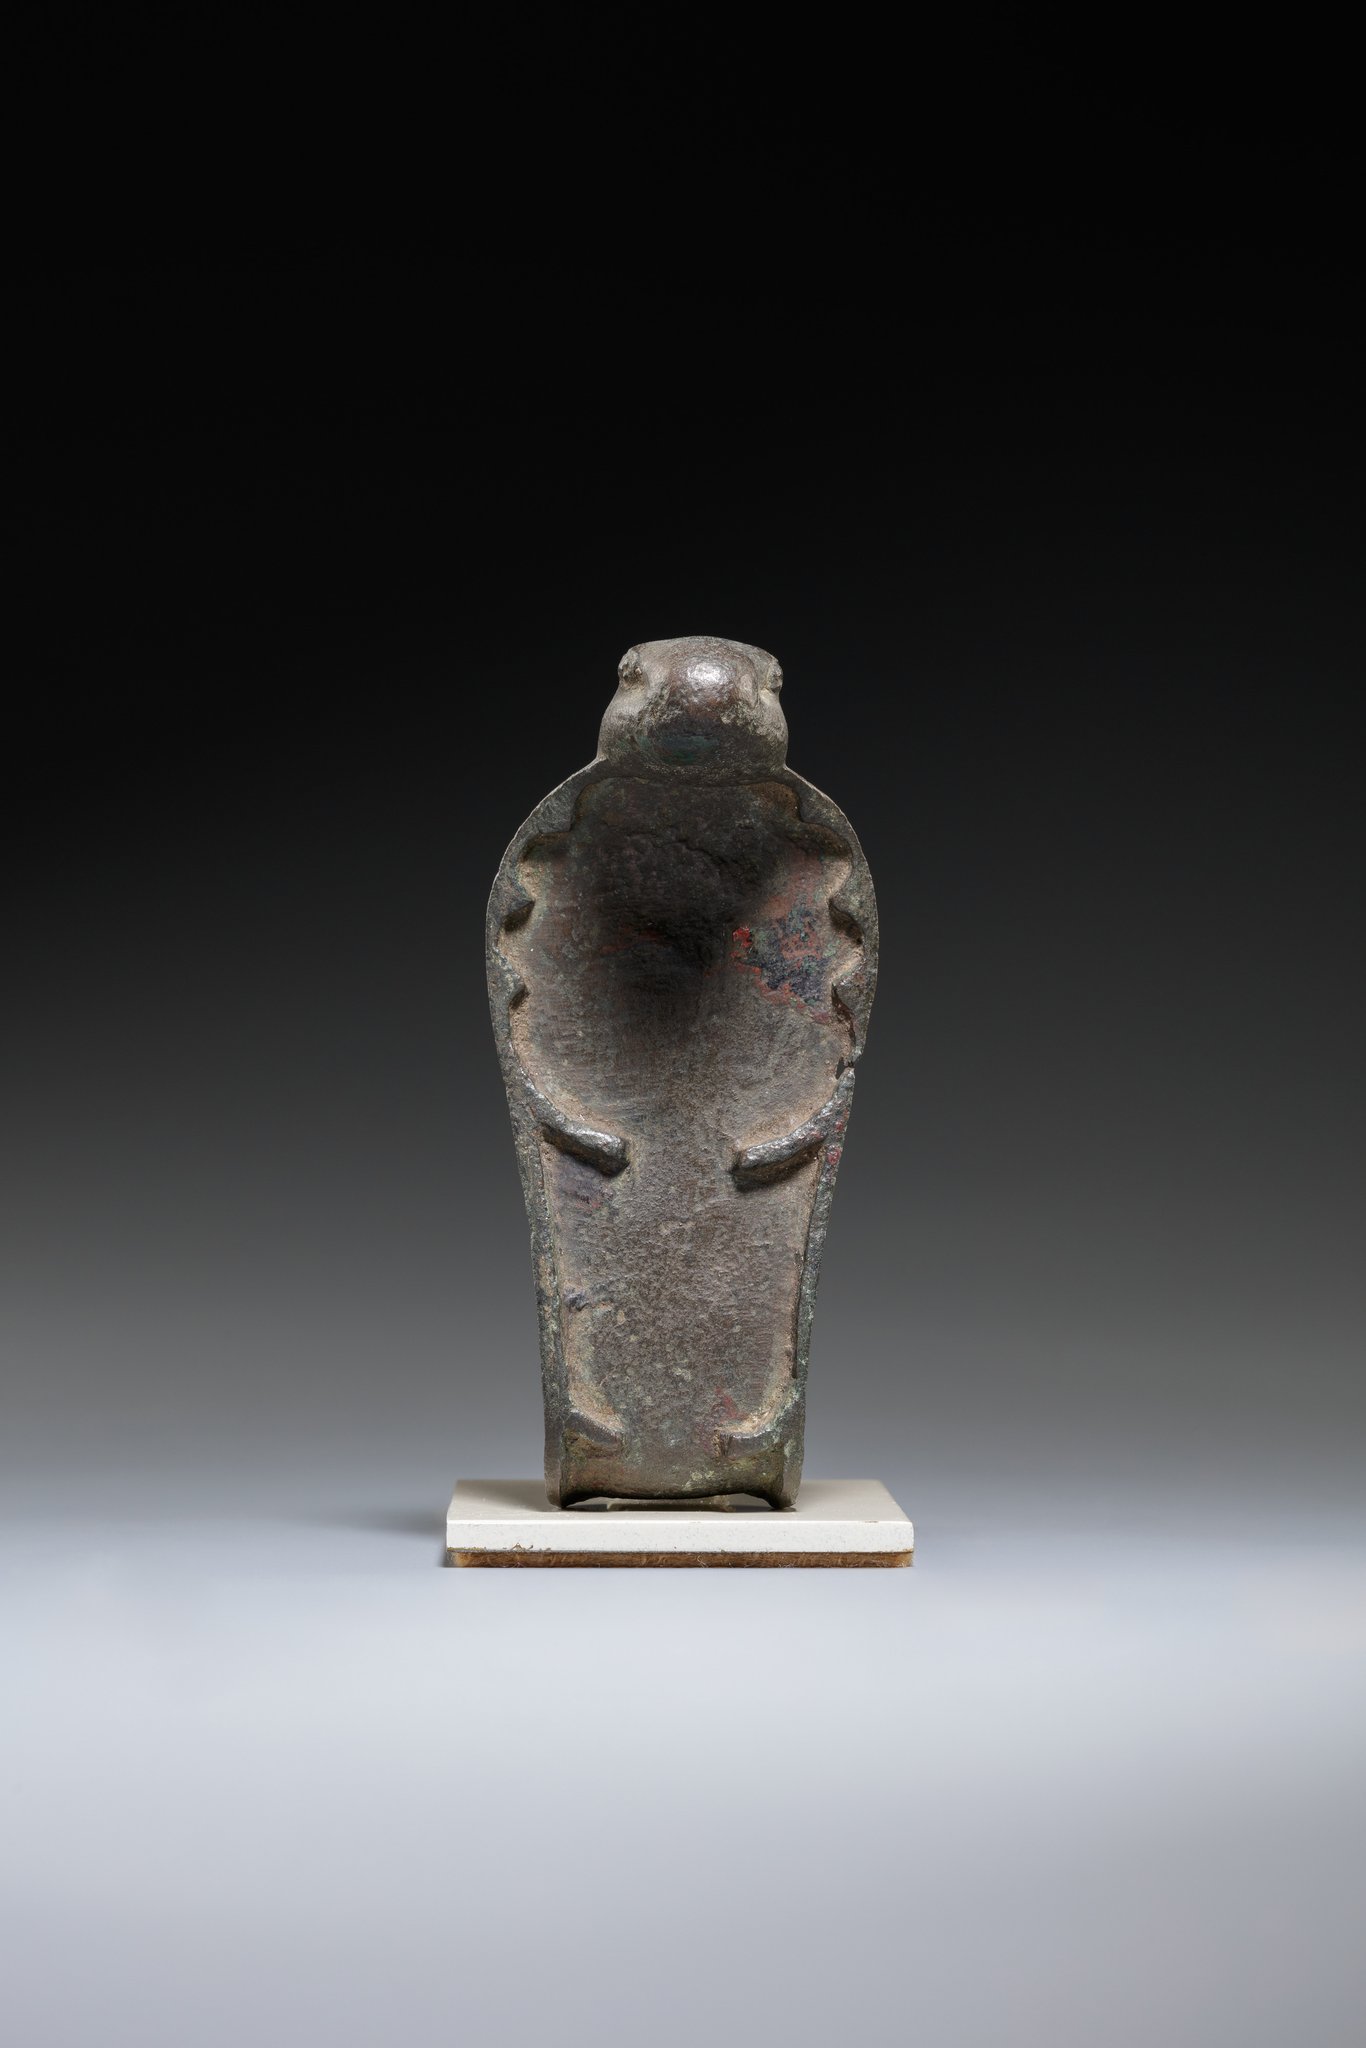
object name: uraeus decoration from shrine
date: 1550-1332 BCE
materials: bronze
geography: egypt